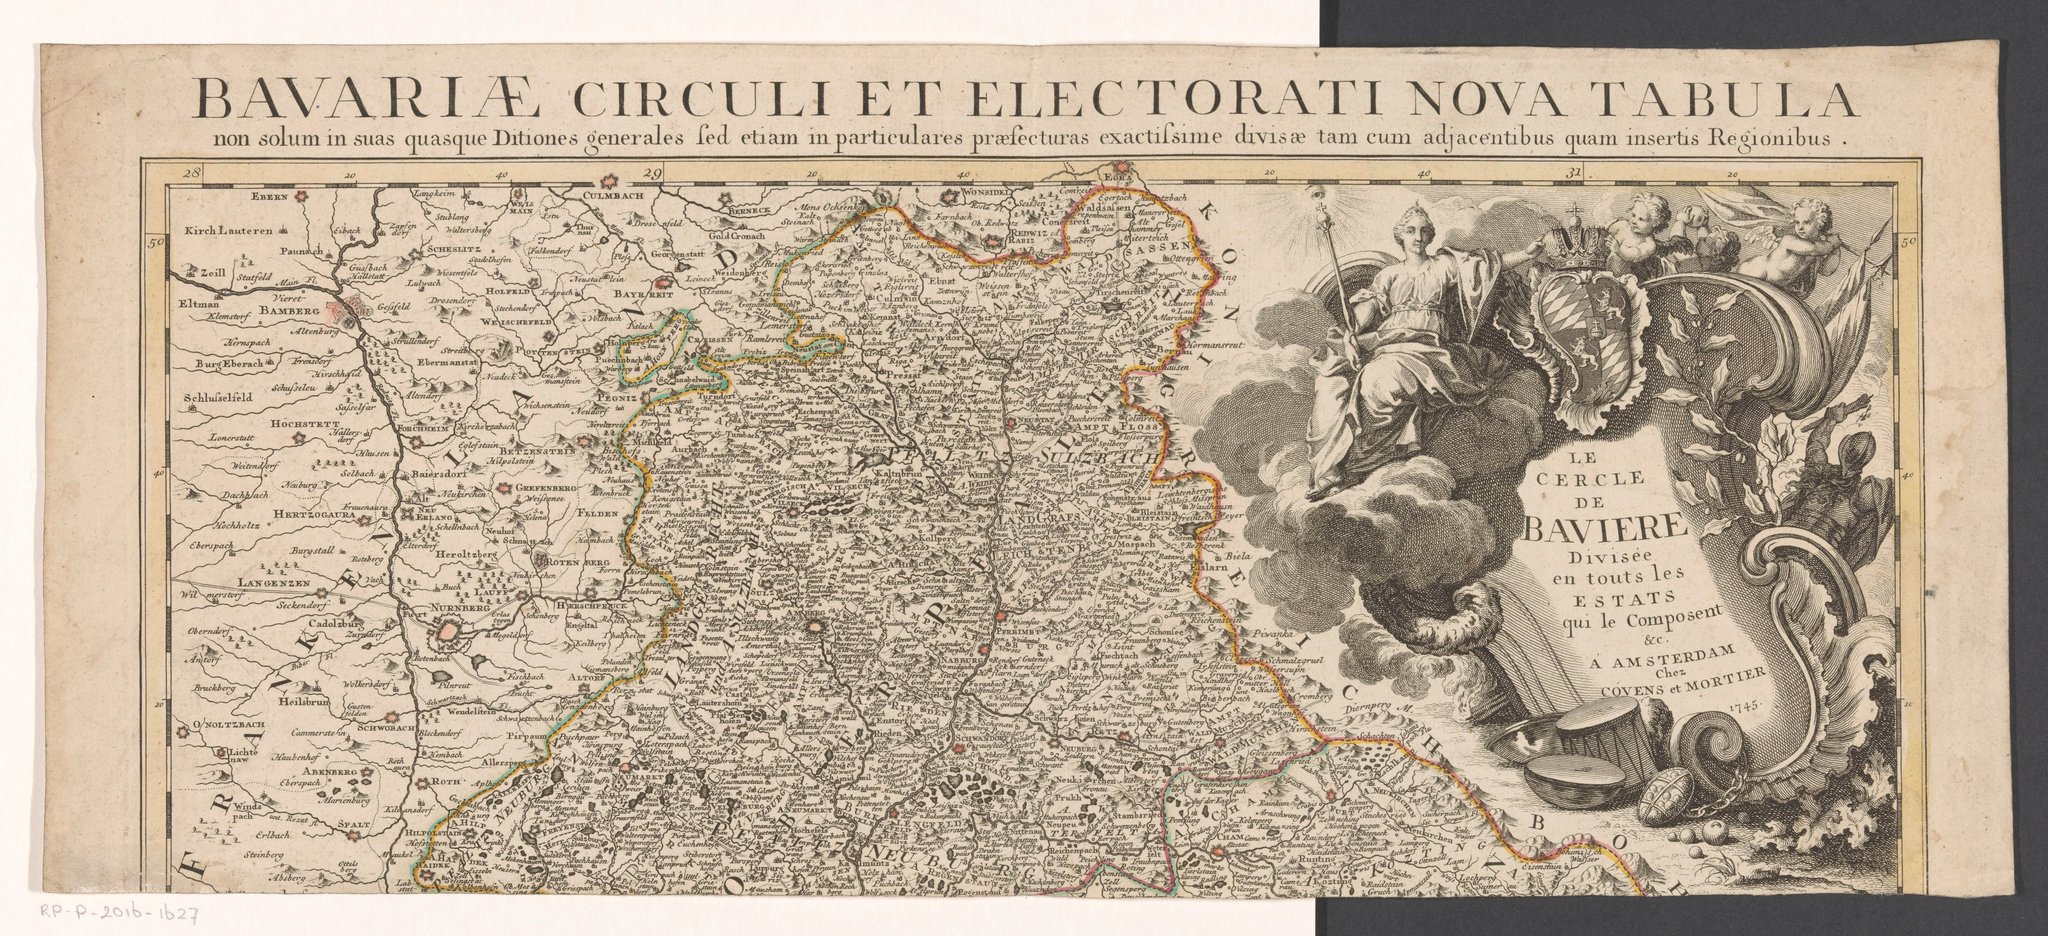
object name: print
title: Cartouche met putti en allegorische vrouwenfiguur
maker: Anonymous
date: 1745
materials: paper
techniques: engraving, etching, hand coloring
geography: amsterdam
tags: sitting figure - aa - female human figure, sceptre, staff (symbol of sovereignty), ornament ~ cartouche, cupids: 'amores', 'amoretti', 'putti'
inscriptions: collector's mark: Lugt 2228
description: Een gekroonde vrouw met scepter waarboven het alziend oog zit naast een gekroond wapenschild van Beieren aan de bovenzijde van een rocaille cartouche met titel. Rechts drie putti en een soldaat op de rug gezien. Detail van een kaart van Beieren.